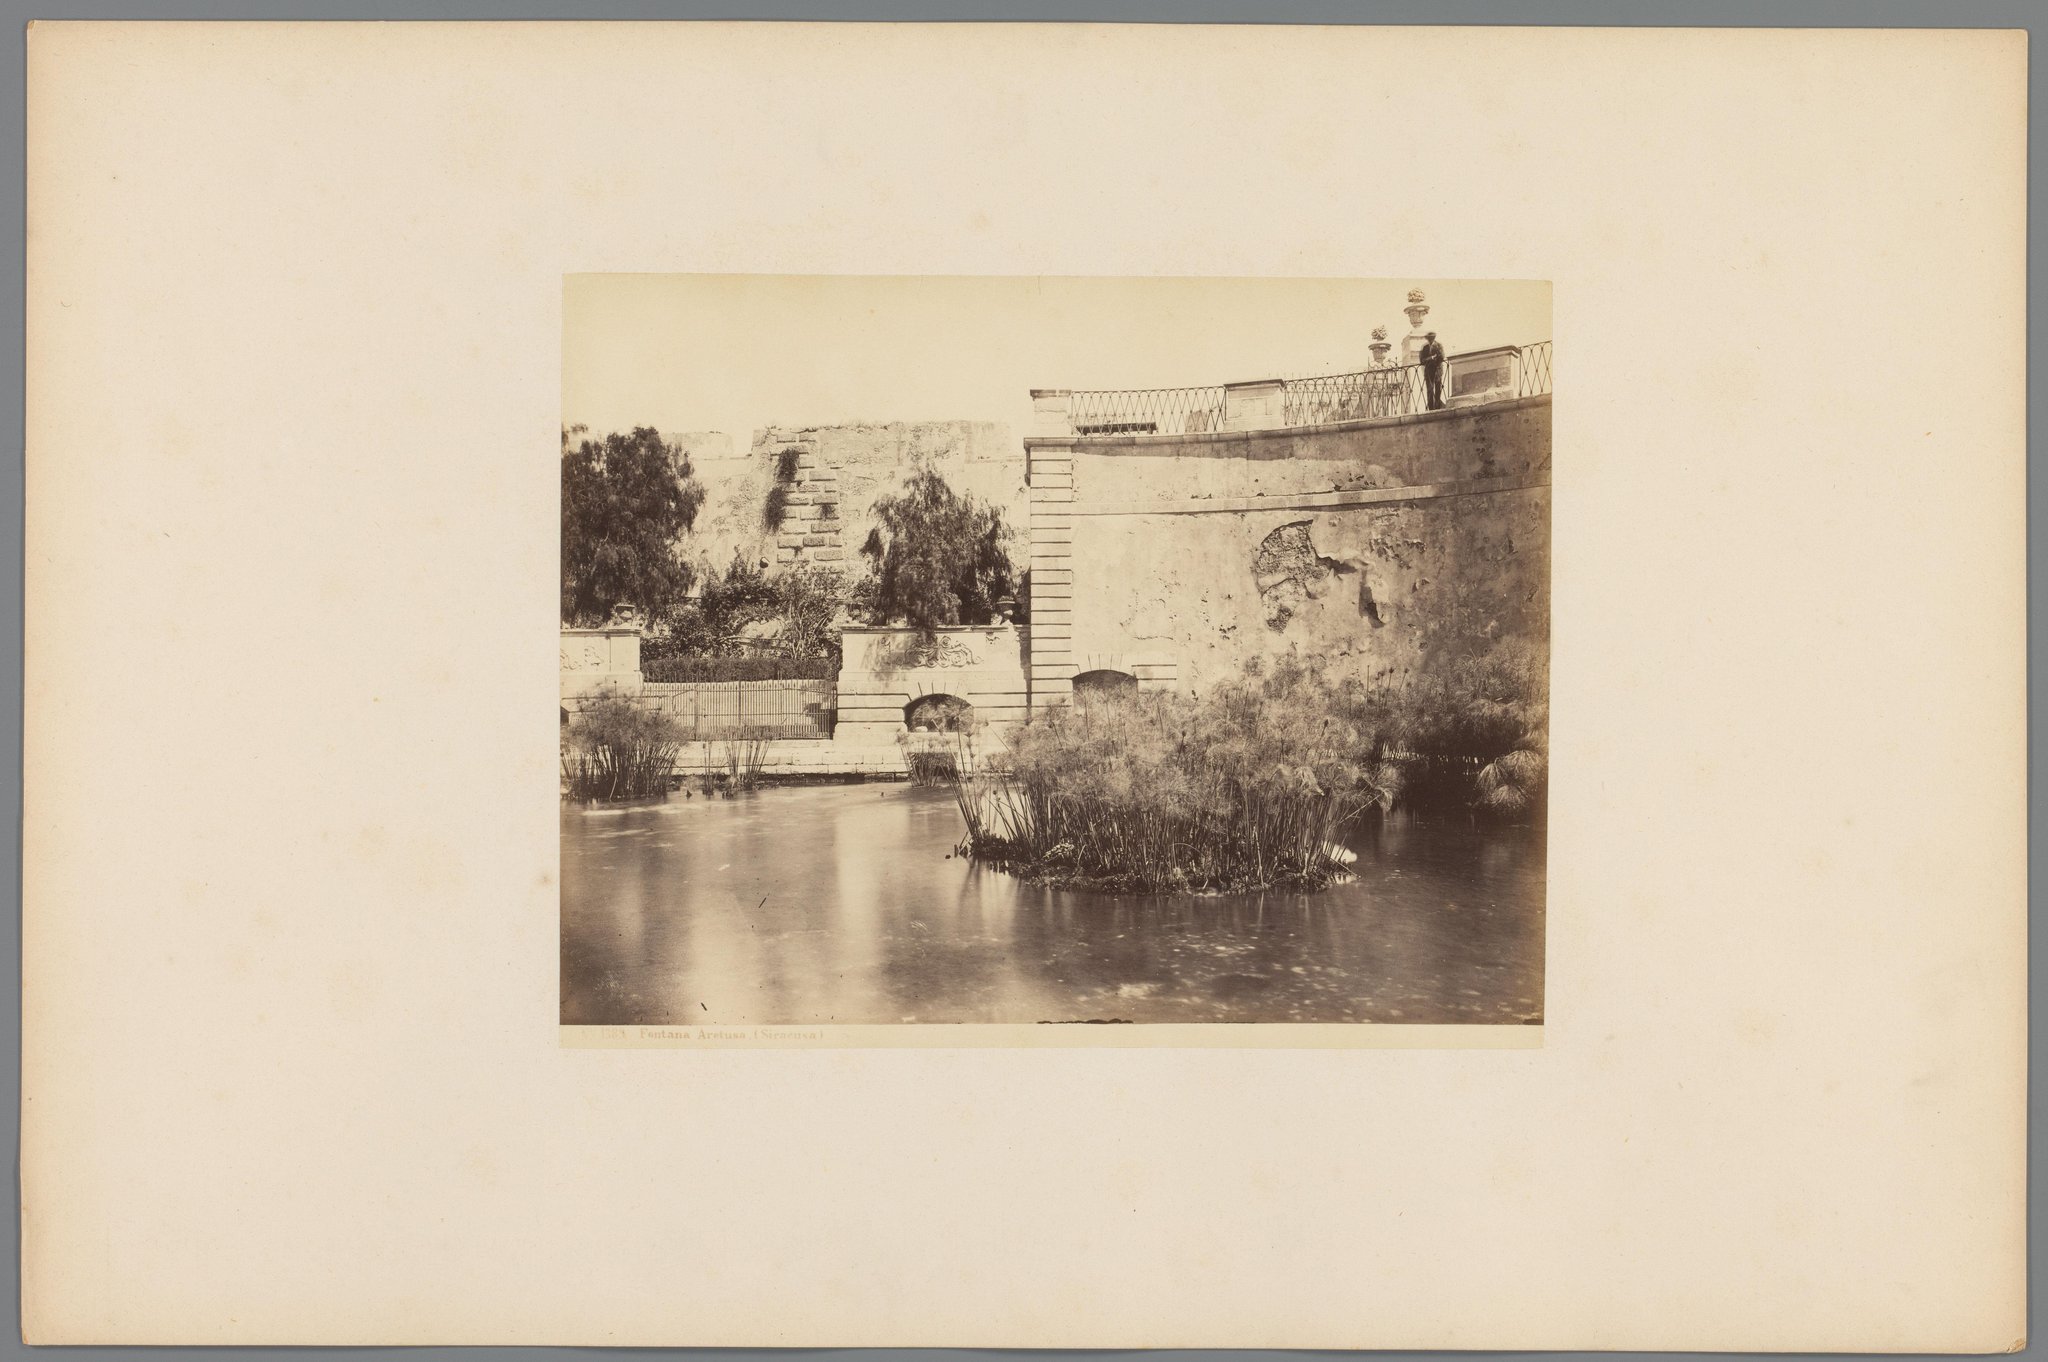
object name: photograph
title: Fontana Aretusa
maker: giorgio sommer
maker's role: fotograaf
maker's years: 1834-1914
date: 1857-1914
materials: cardboard, paper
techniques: albumen print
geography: syracuse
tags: pond, pool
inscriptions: number: ‘No. 1389’